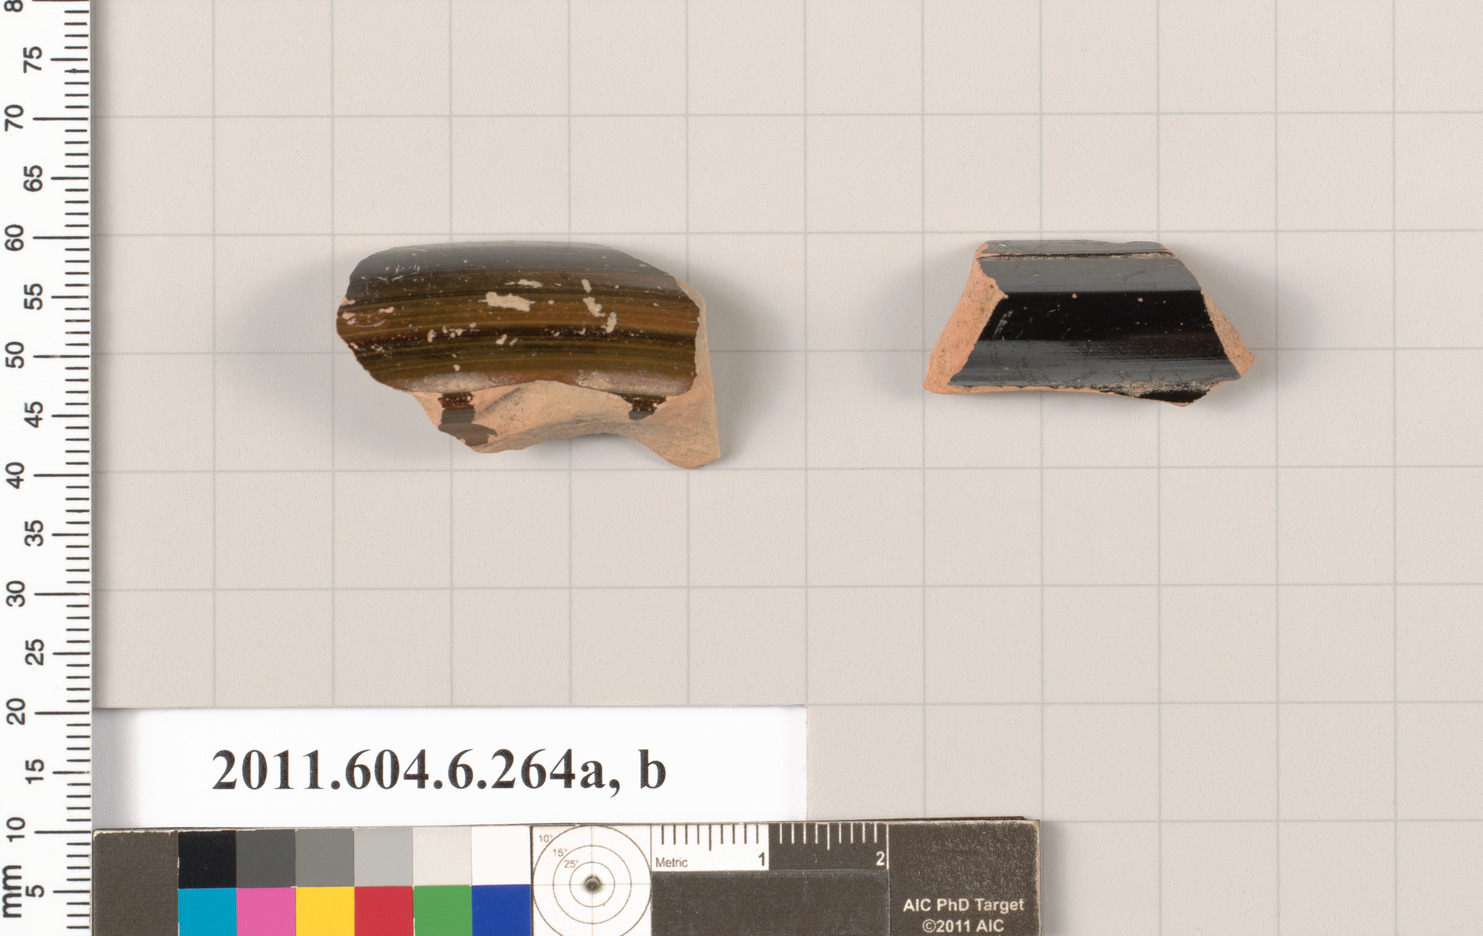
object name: undetermined shape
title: Terracotta fragments of undetermined shapes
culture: greek, attic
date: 500-401 BCE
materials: terracotta